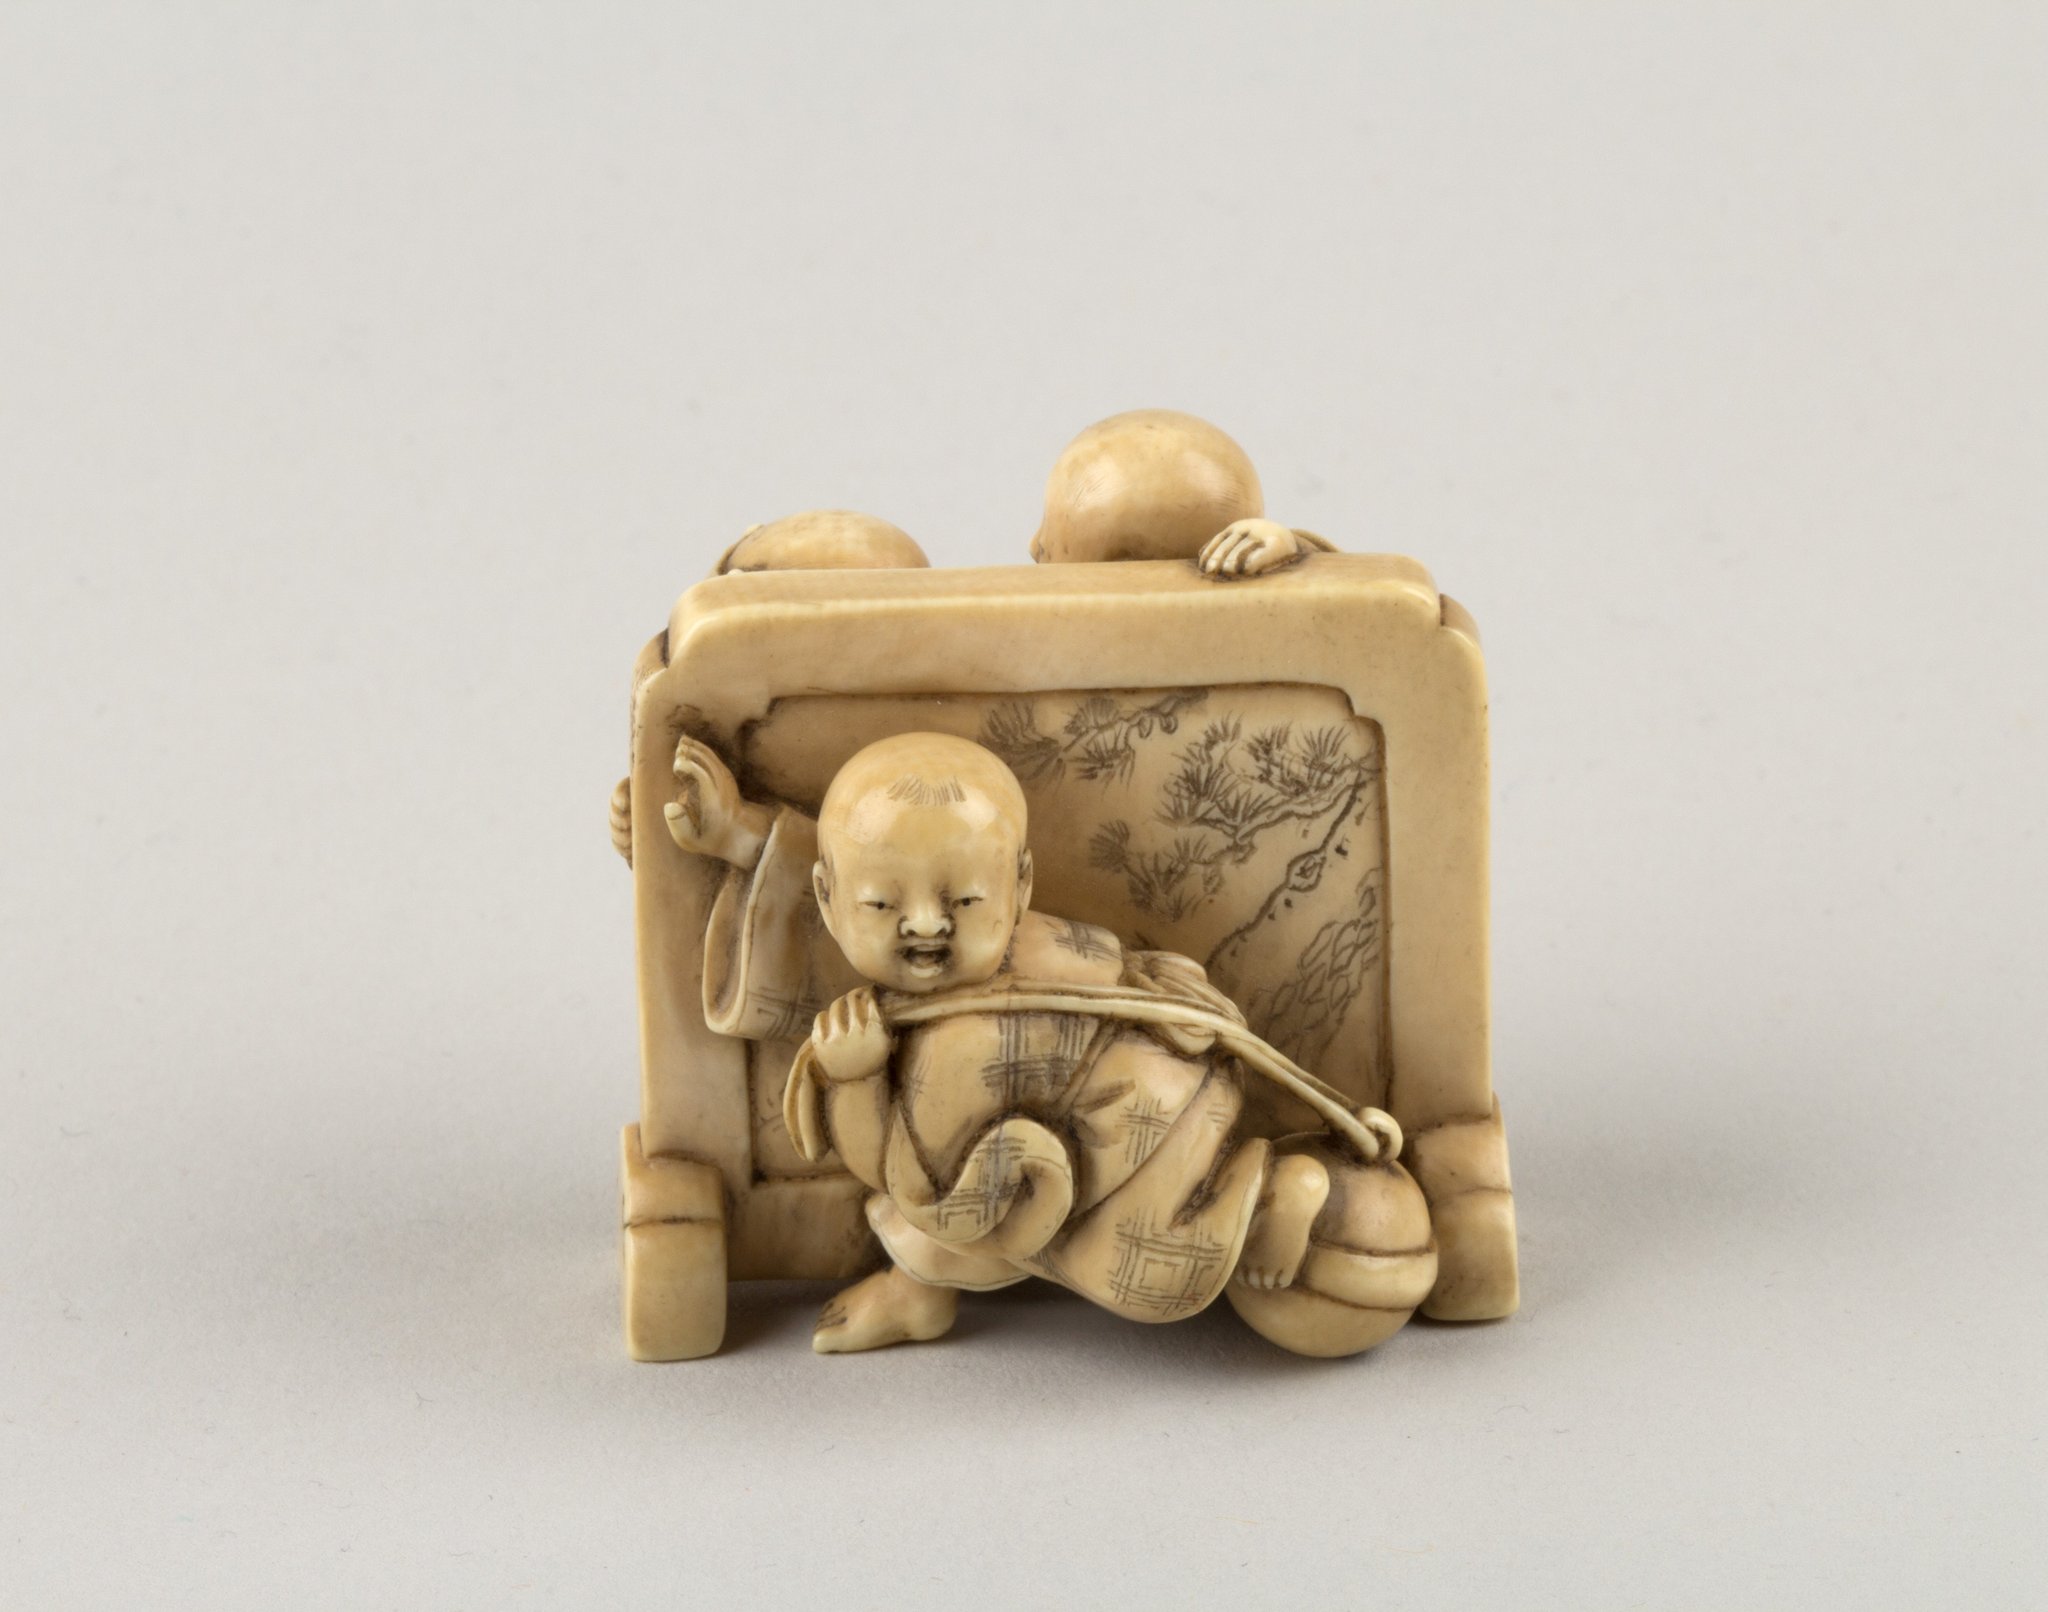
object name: netsuke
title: Netsuke of Three Boys Playing around a Screen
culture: japanese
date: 1701-1800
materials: ivory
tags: boys